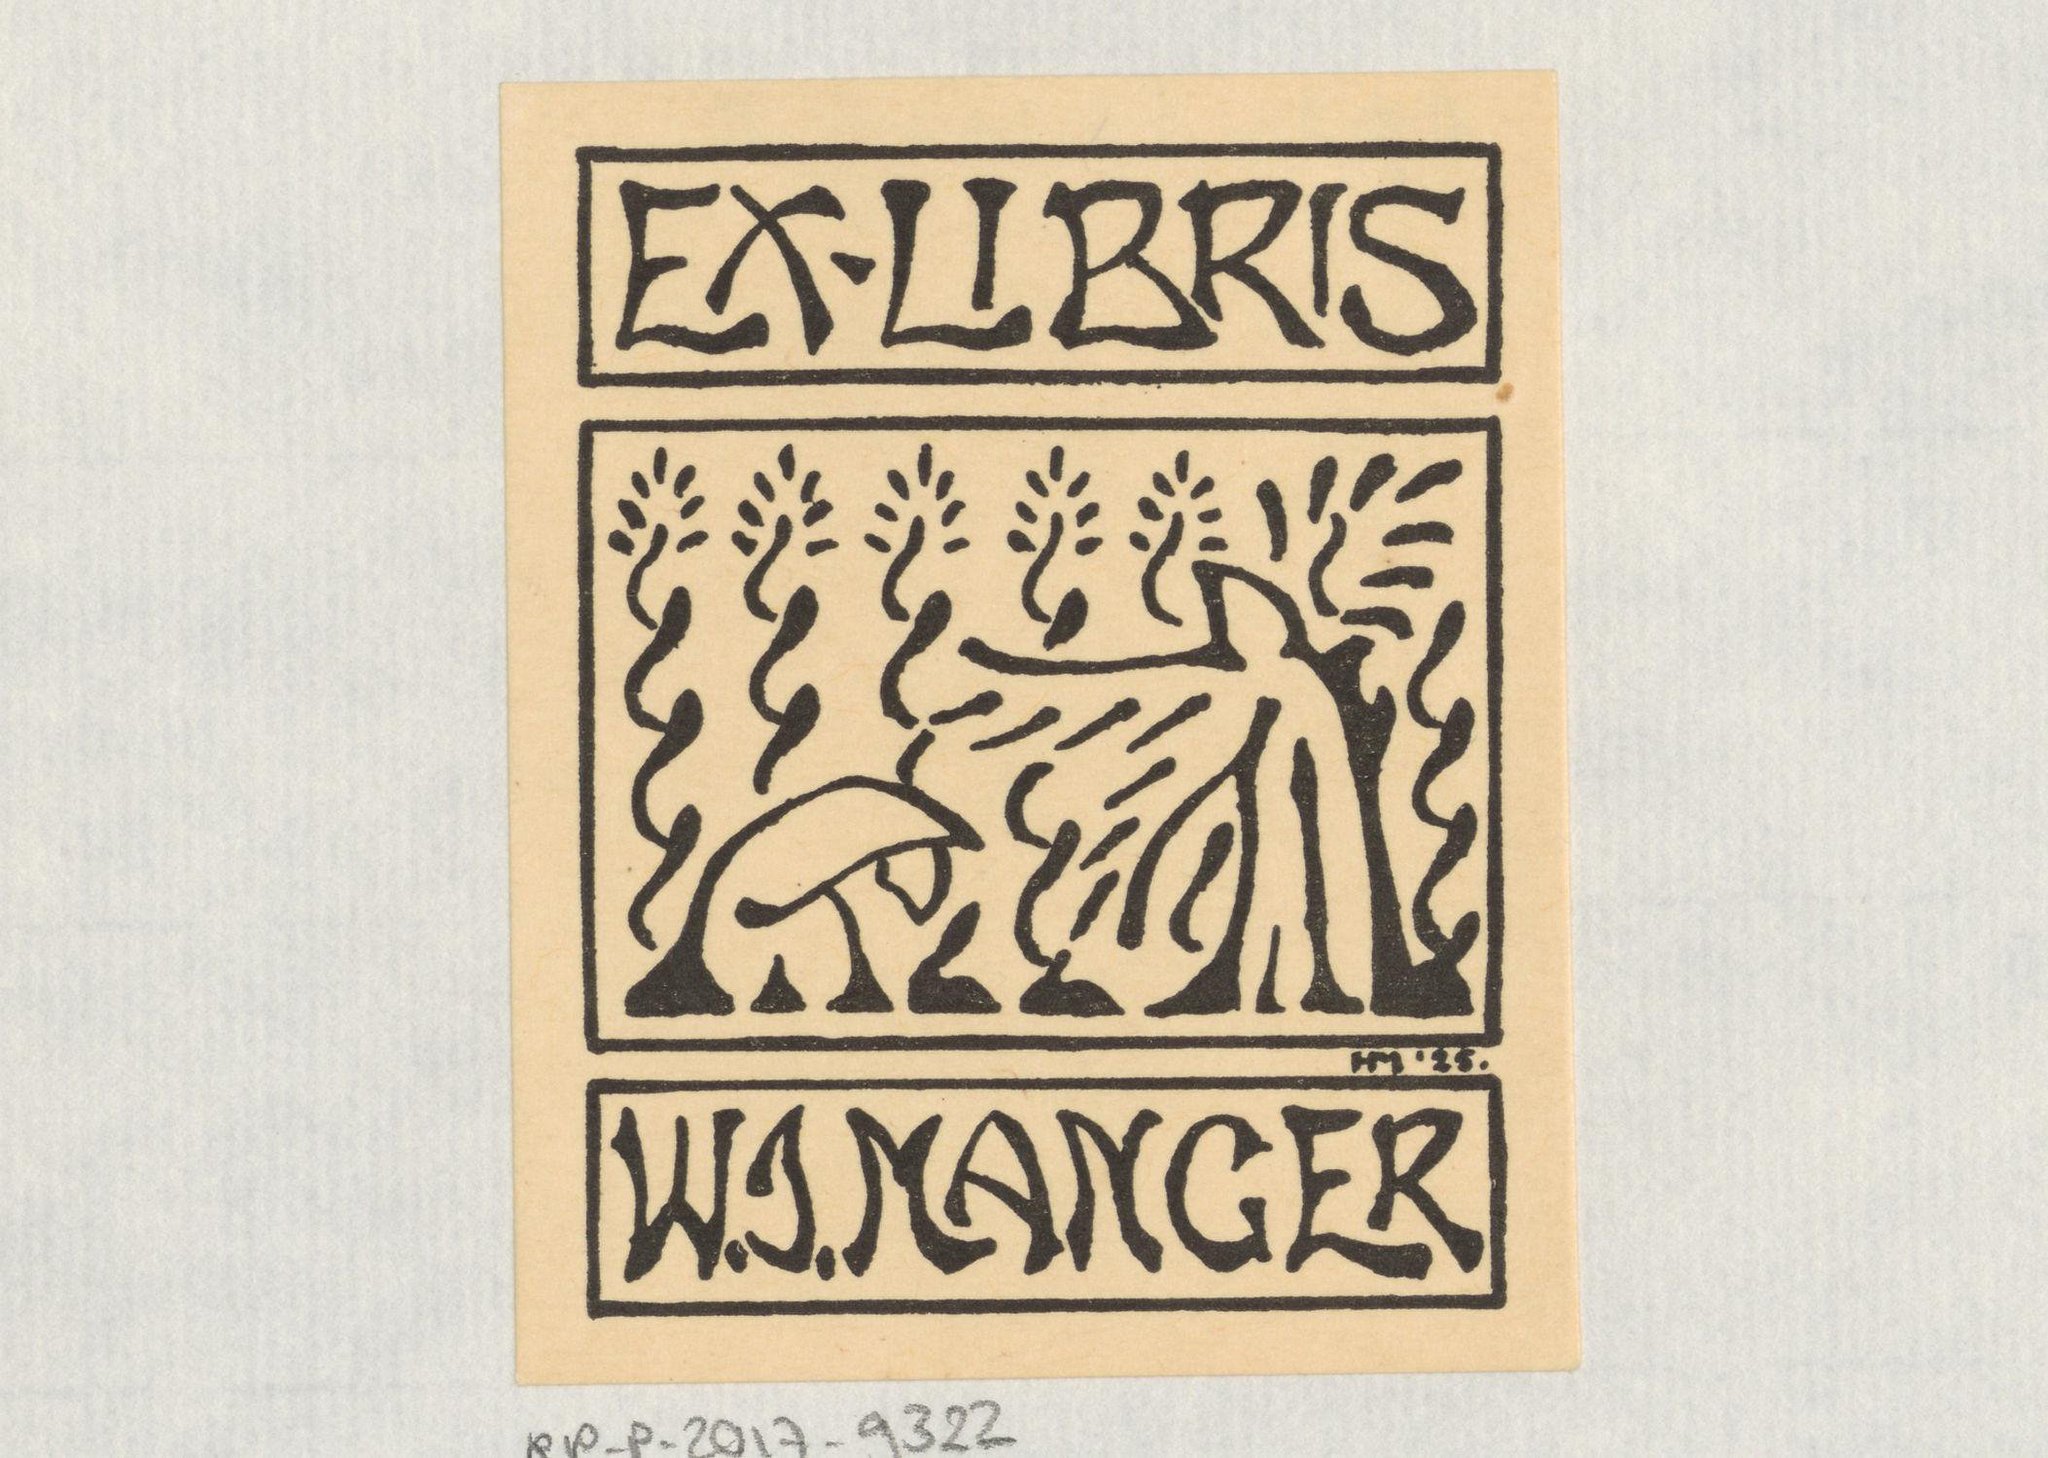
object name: bookplate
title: Ex libris van W.J. Manger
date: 1925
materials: paper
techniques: printing block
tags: standing figure, kneeling figure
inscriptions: date